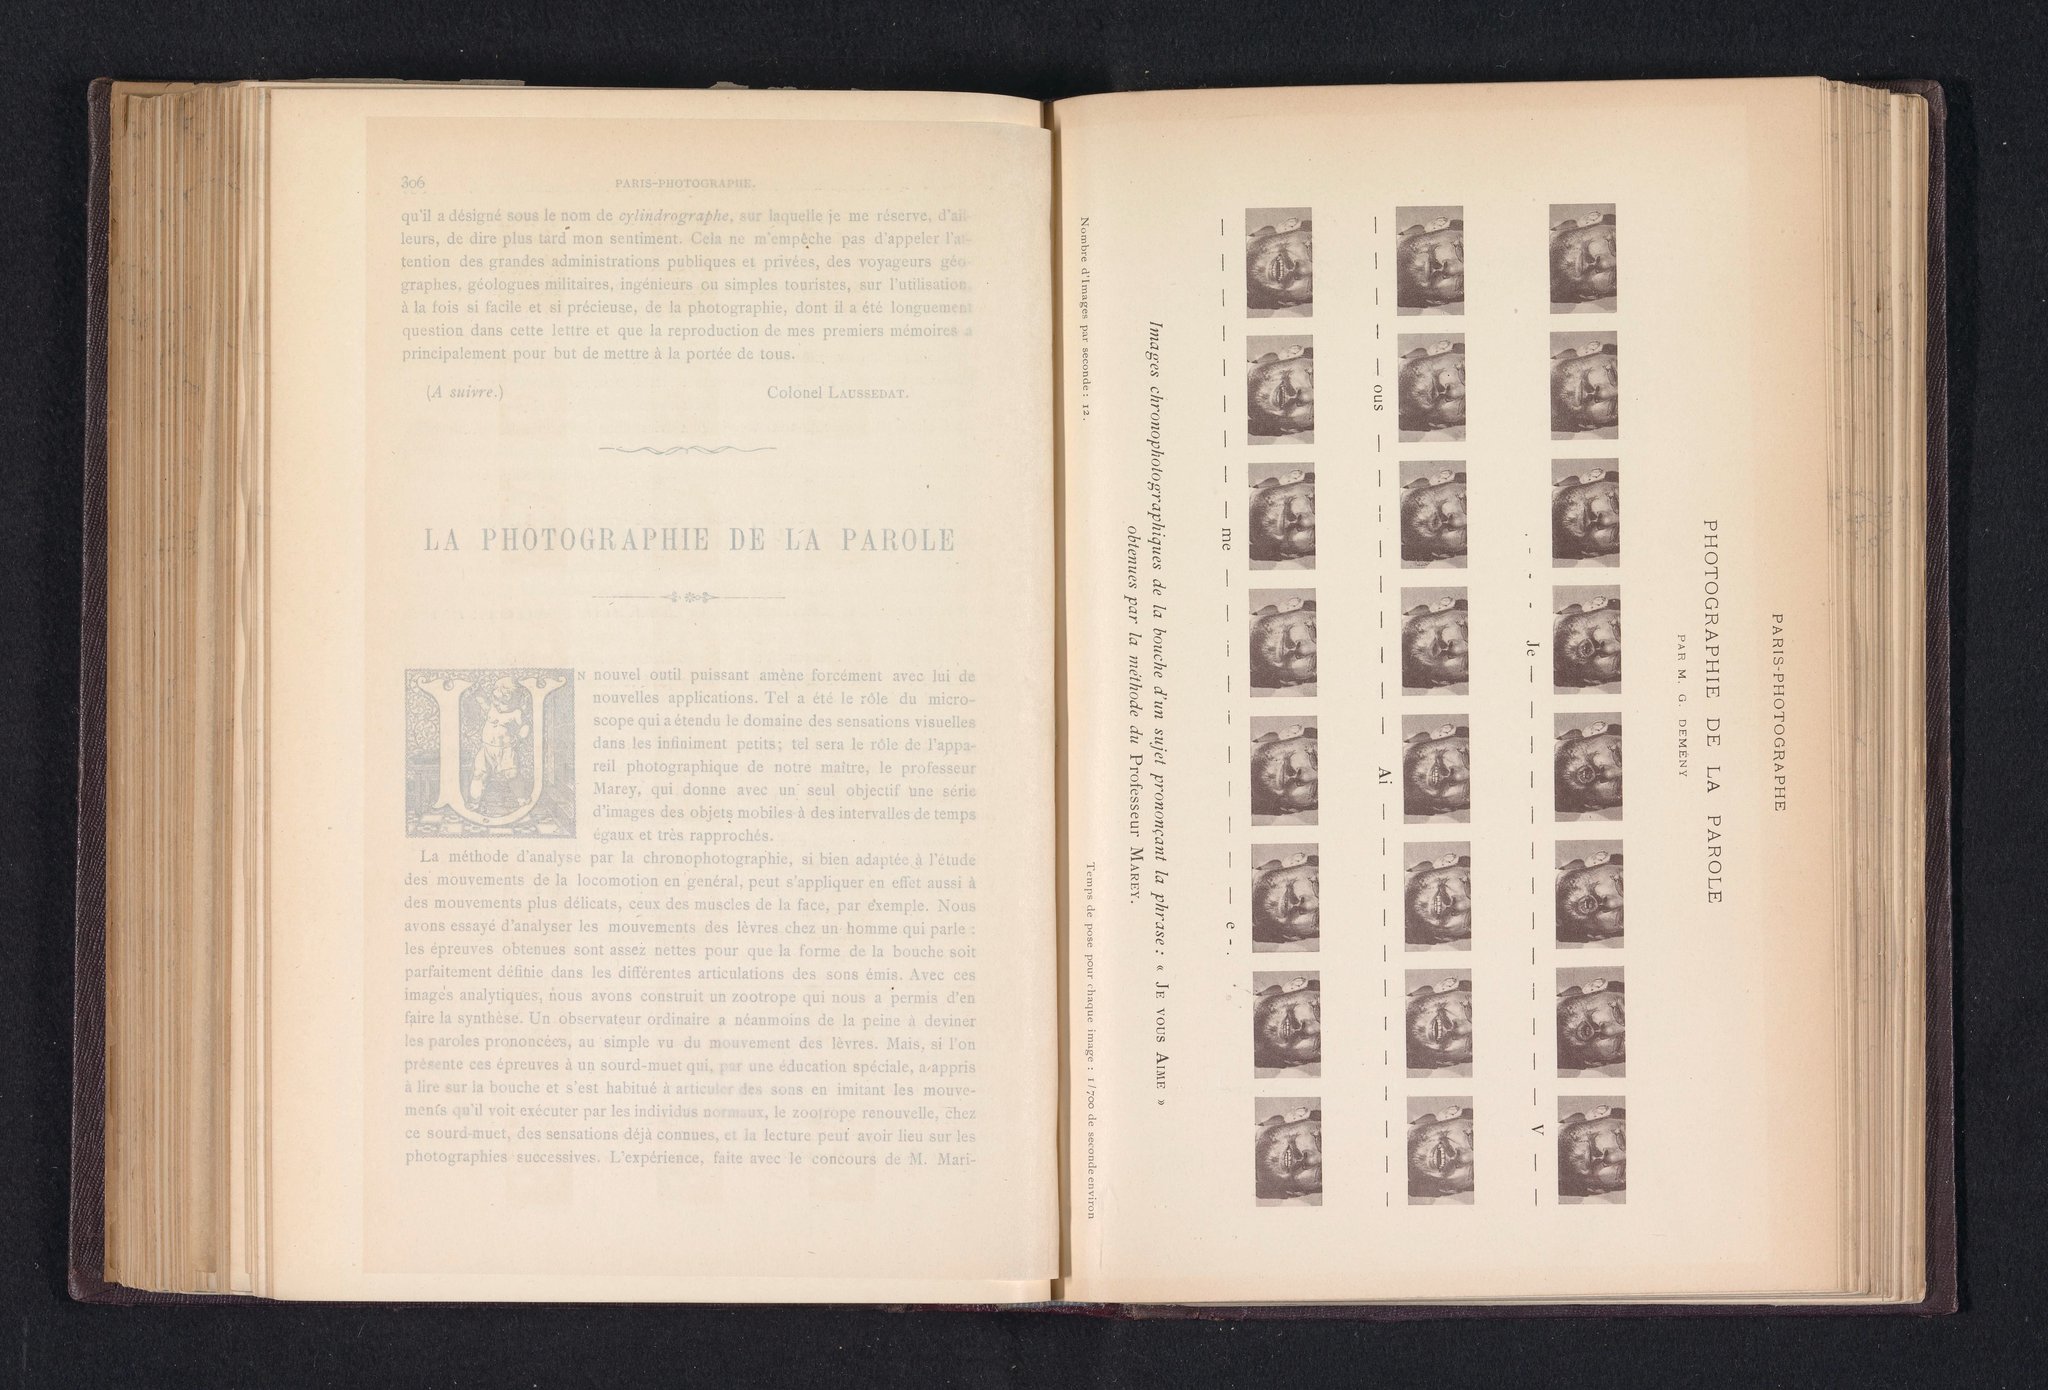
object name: photomechanical print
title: Photographie de la parole, images chromophotographiques de la bouche d'un sujet prononcant la phrase: 'Je vous aime' obtenues par la methode du Professeur Marey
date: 1881-1891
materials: paper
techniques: photograph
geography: france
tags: speaking, mouth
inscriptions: inscription: ‘Nombre d'Images par seconde: 12. Temps de pose pour chaque image: 1/700 de seconde environ’